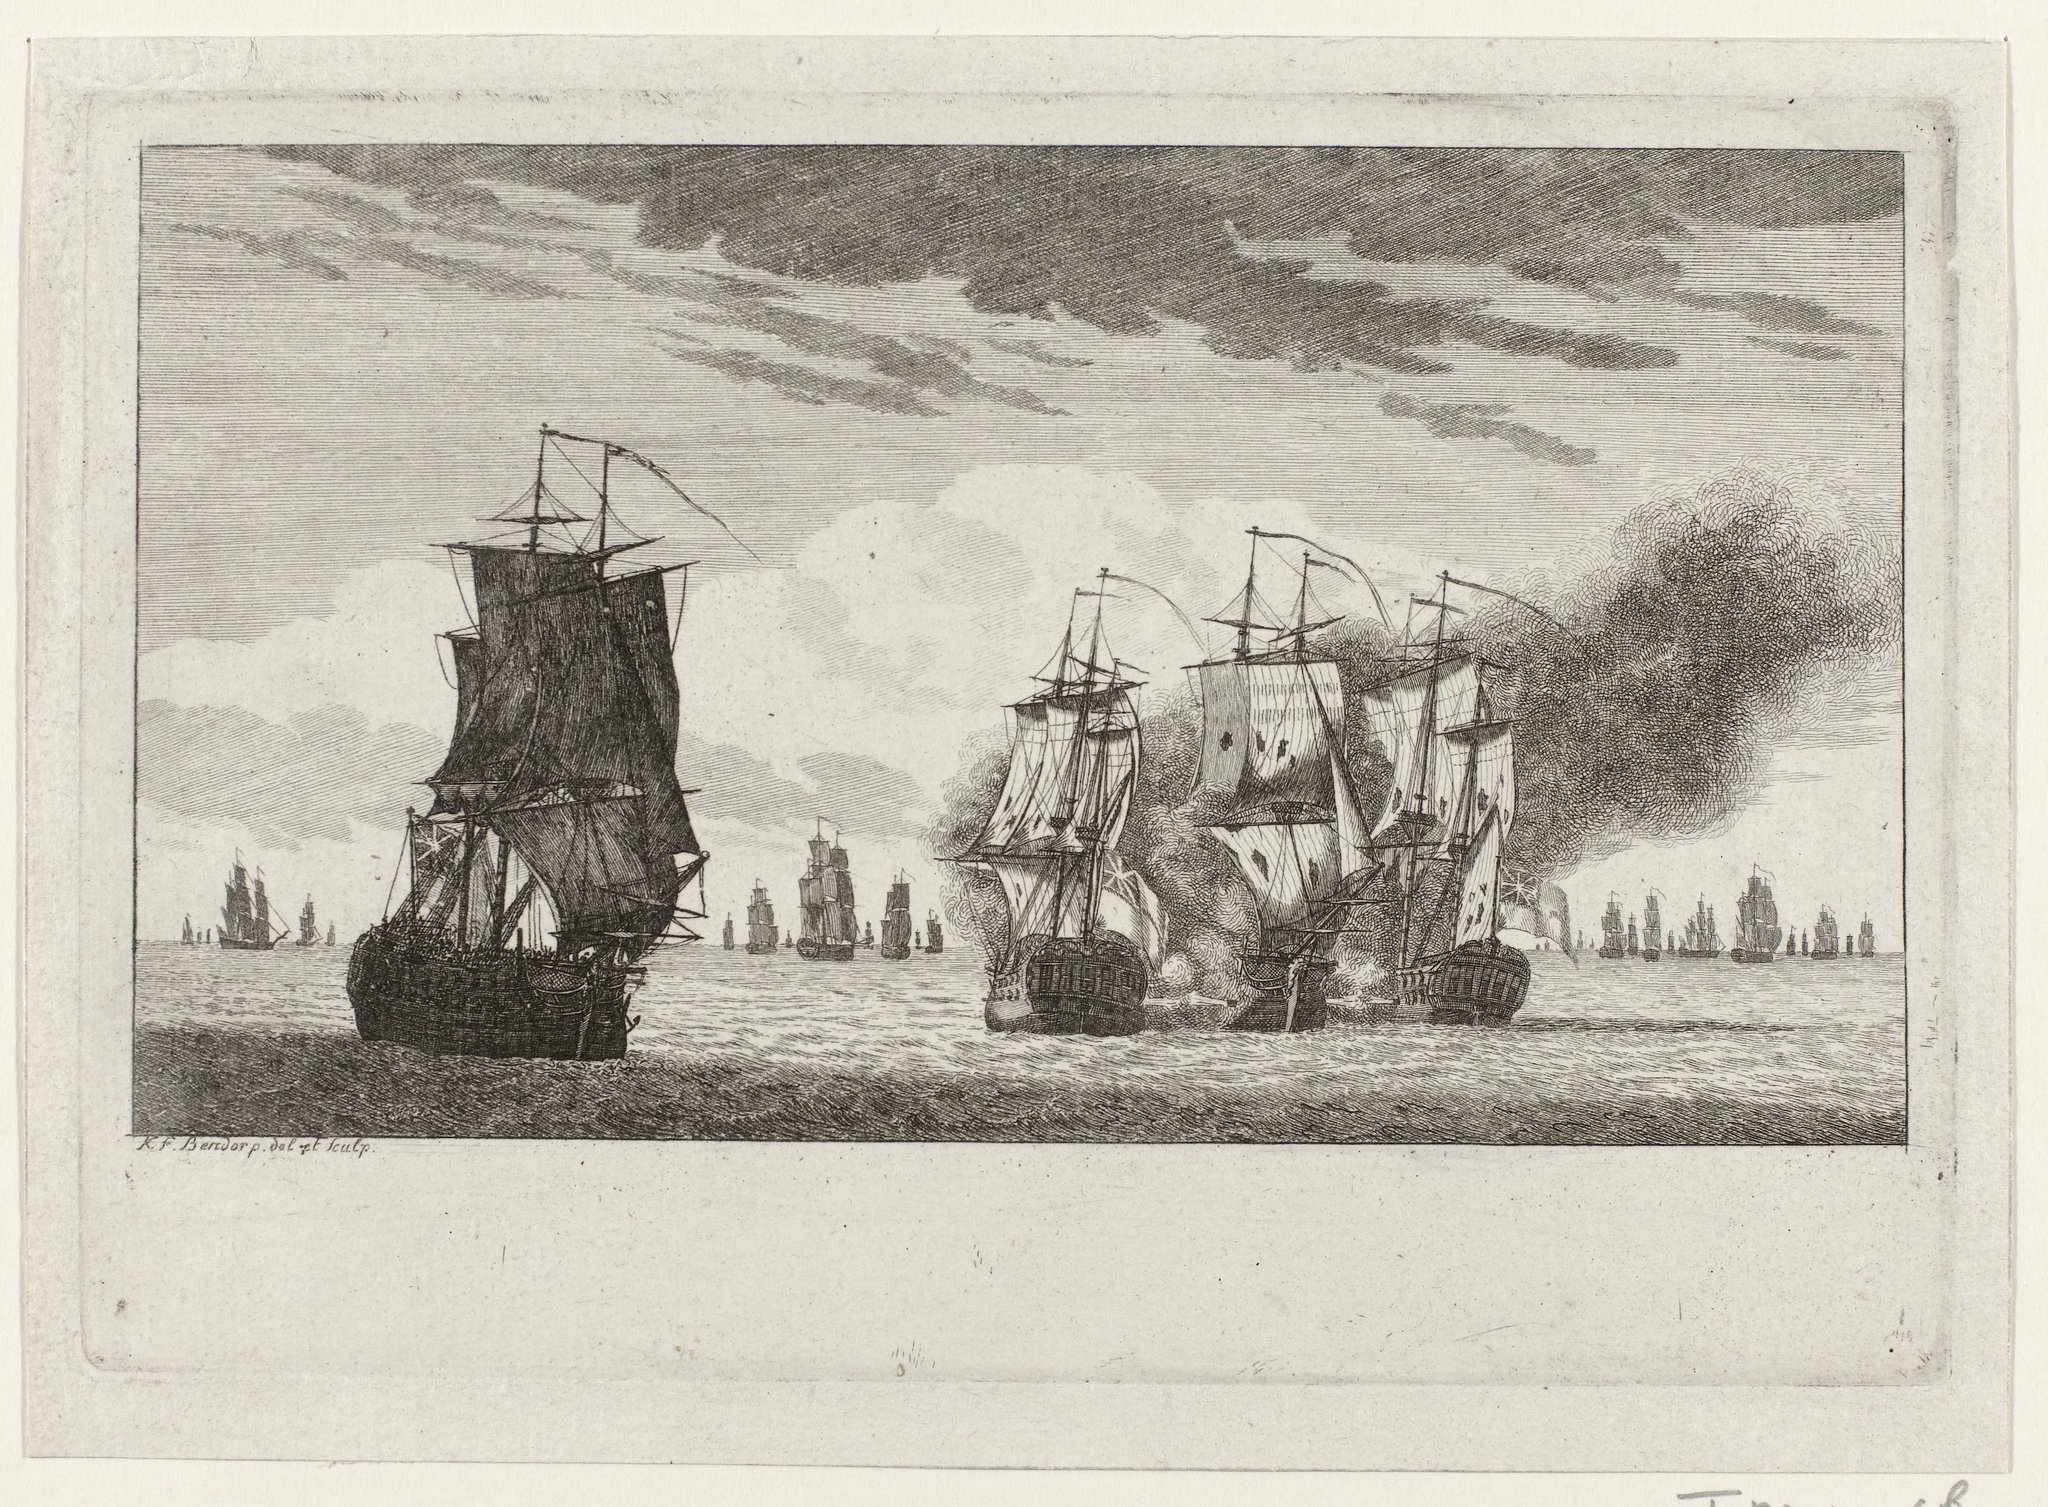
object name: print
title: Willem Crul aangevallen door de Engelsen, 1781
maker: carel frederik bendorp (i)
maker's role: print maker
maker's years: 1736-1814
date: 1781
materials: paper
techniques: engraving, etching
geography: northern netherlands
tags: battle (+ naval force)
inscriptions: collector's mark: Lugt 2228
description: Het Nederlandse oorlogsschip Mars onder bevel van schout-bij-nacht Willem Crul aangevallen door drie Engelse oorlogsschepen op 4 februari 1781. De Mars begeleidde een konvooi Nederlandse koopvaarders van Sint-Eustatius.